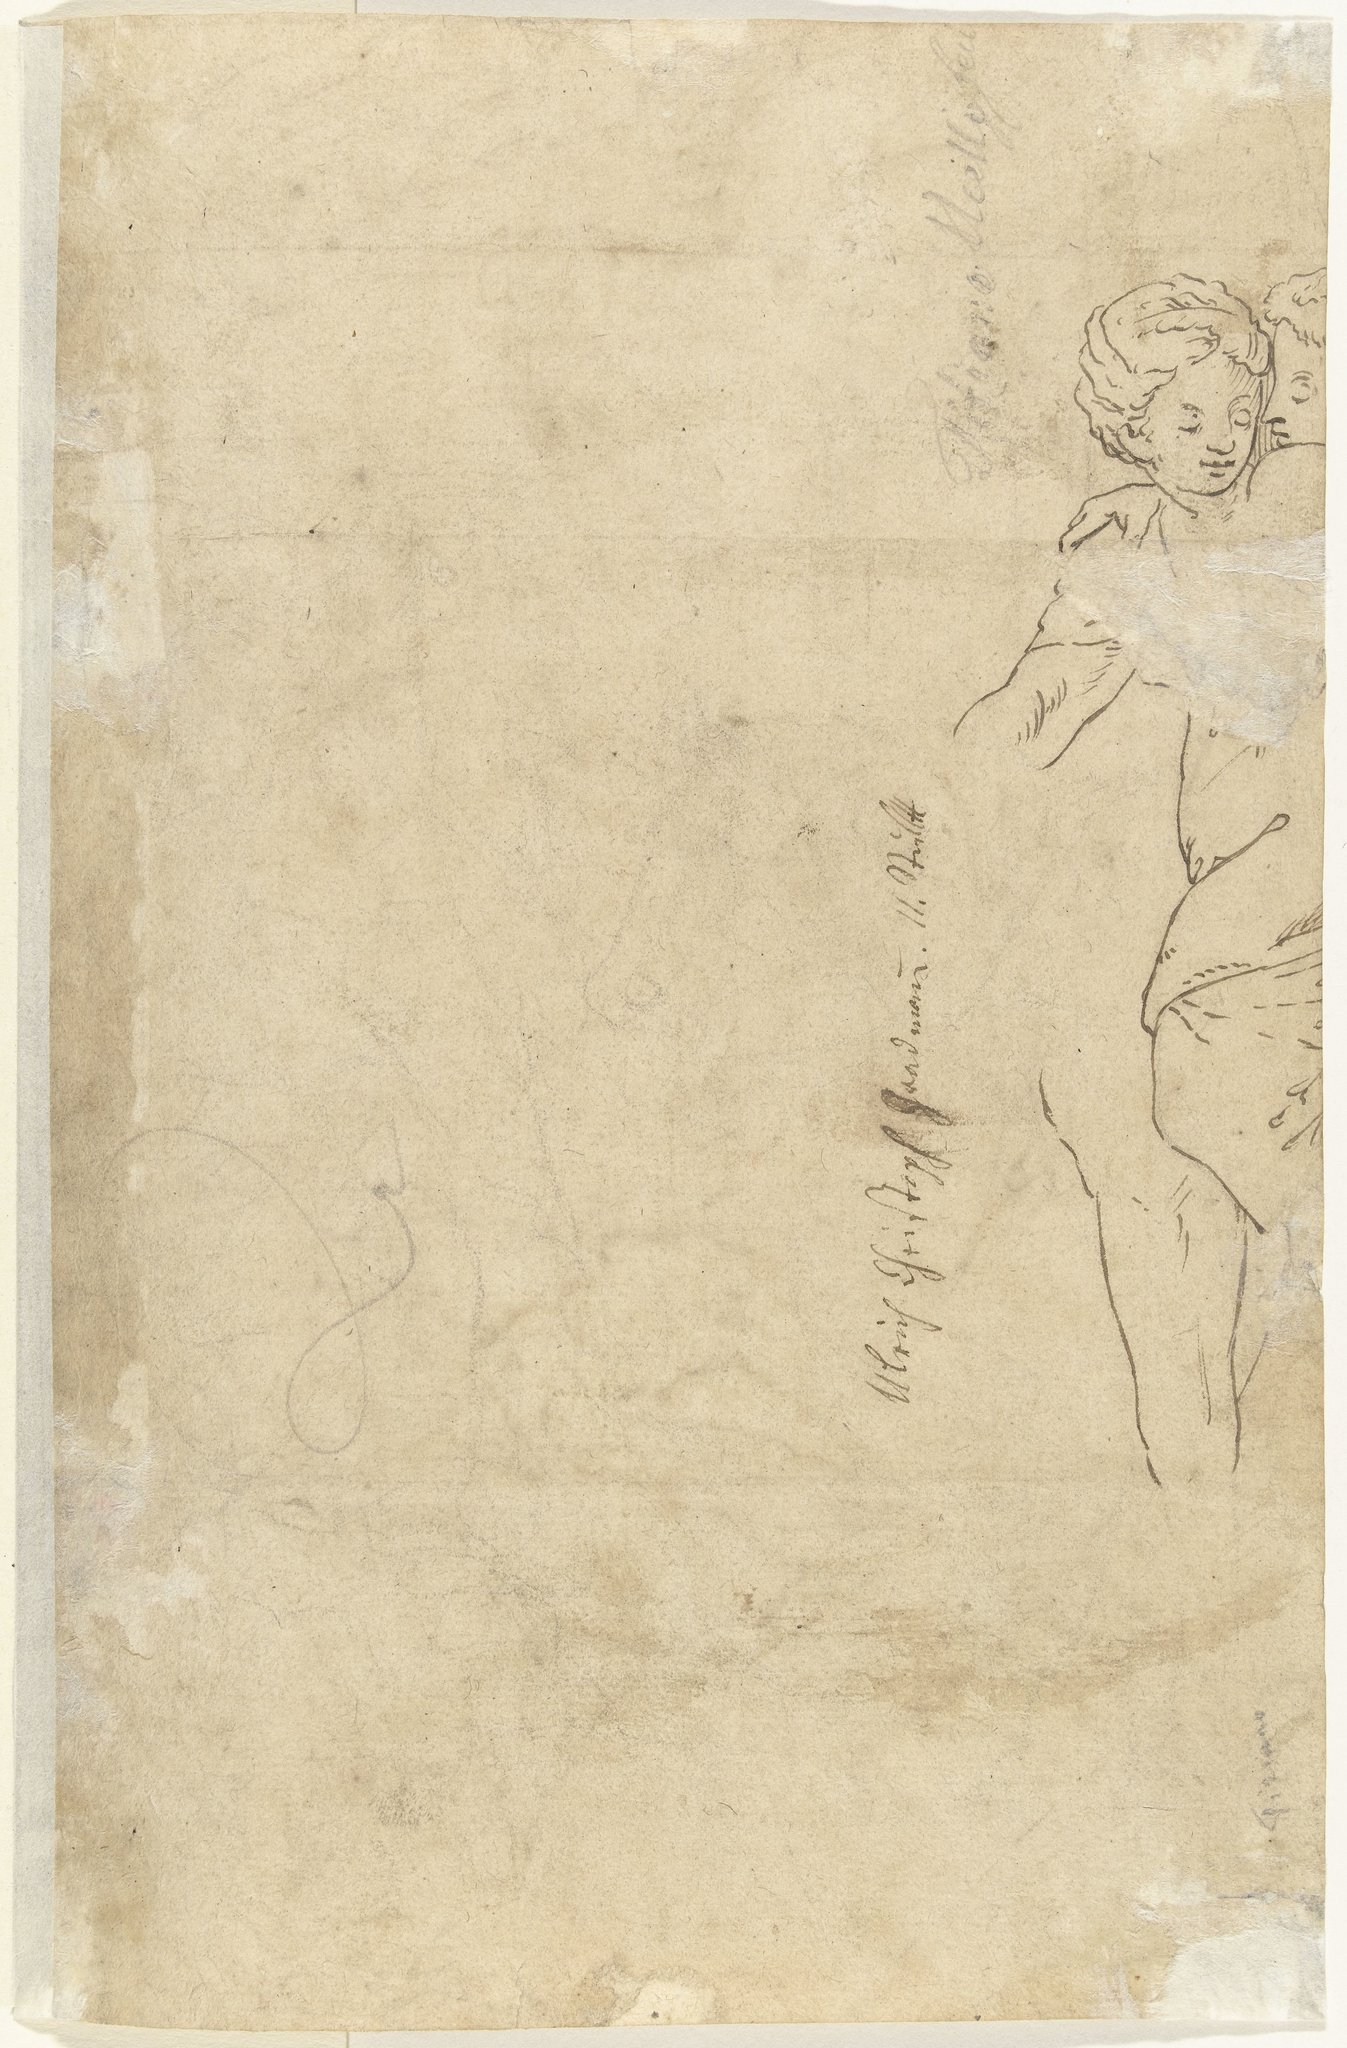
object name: drawing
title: Fragment van een staande jonge vrouw die omhelsd wordt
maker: Anonymous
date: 1600-1699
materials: ink, paper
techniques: pen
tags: embracing each other, kissing